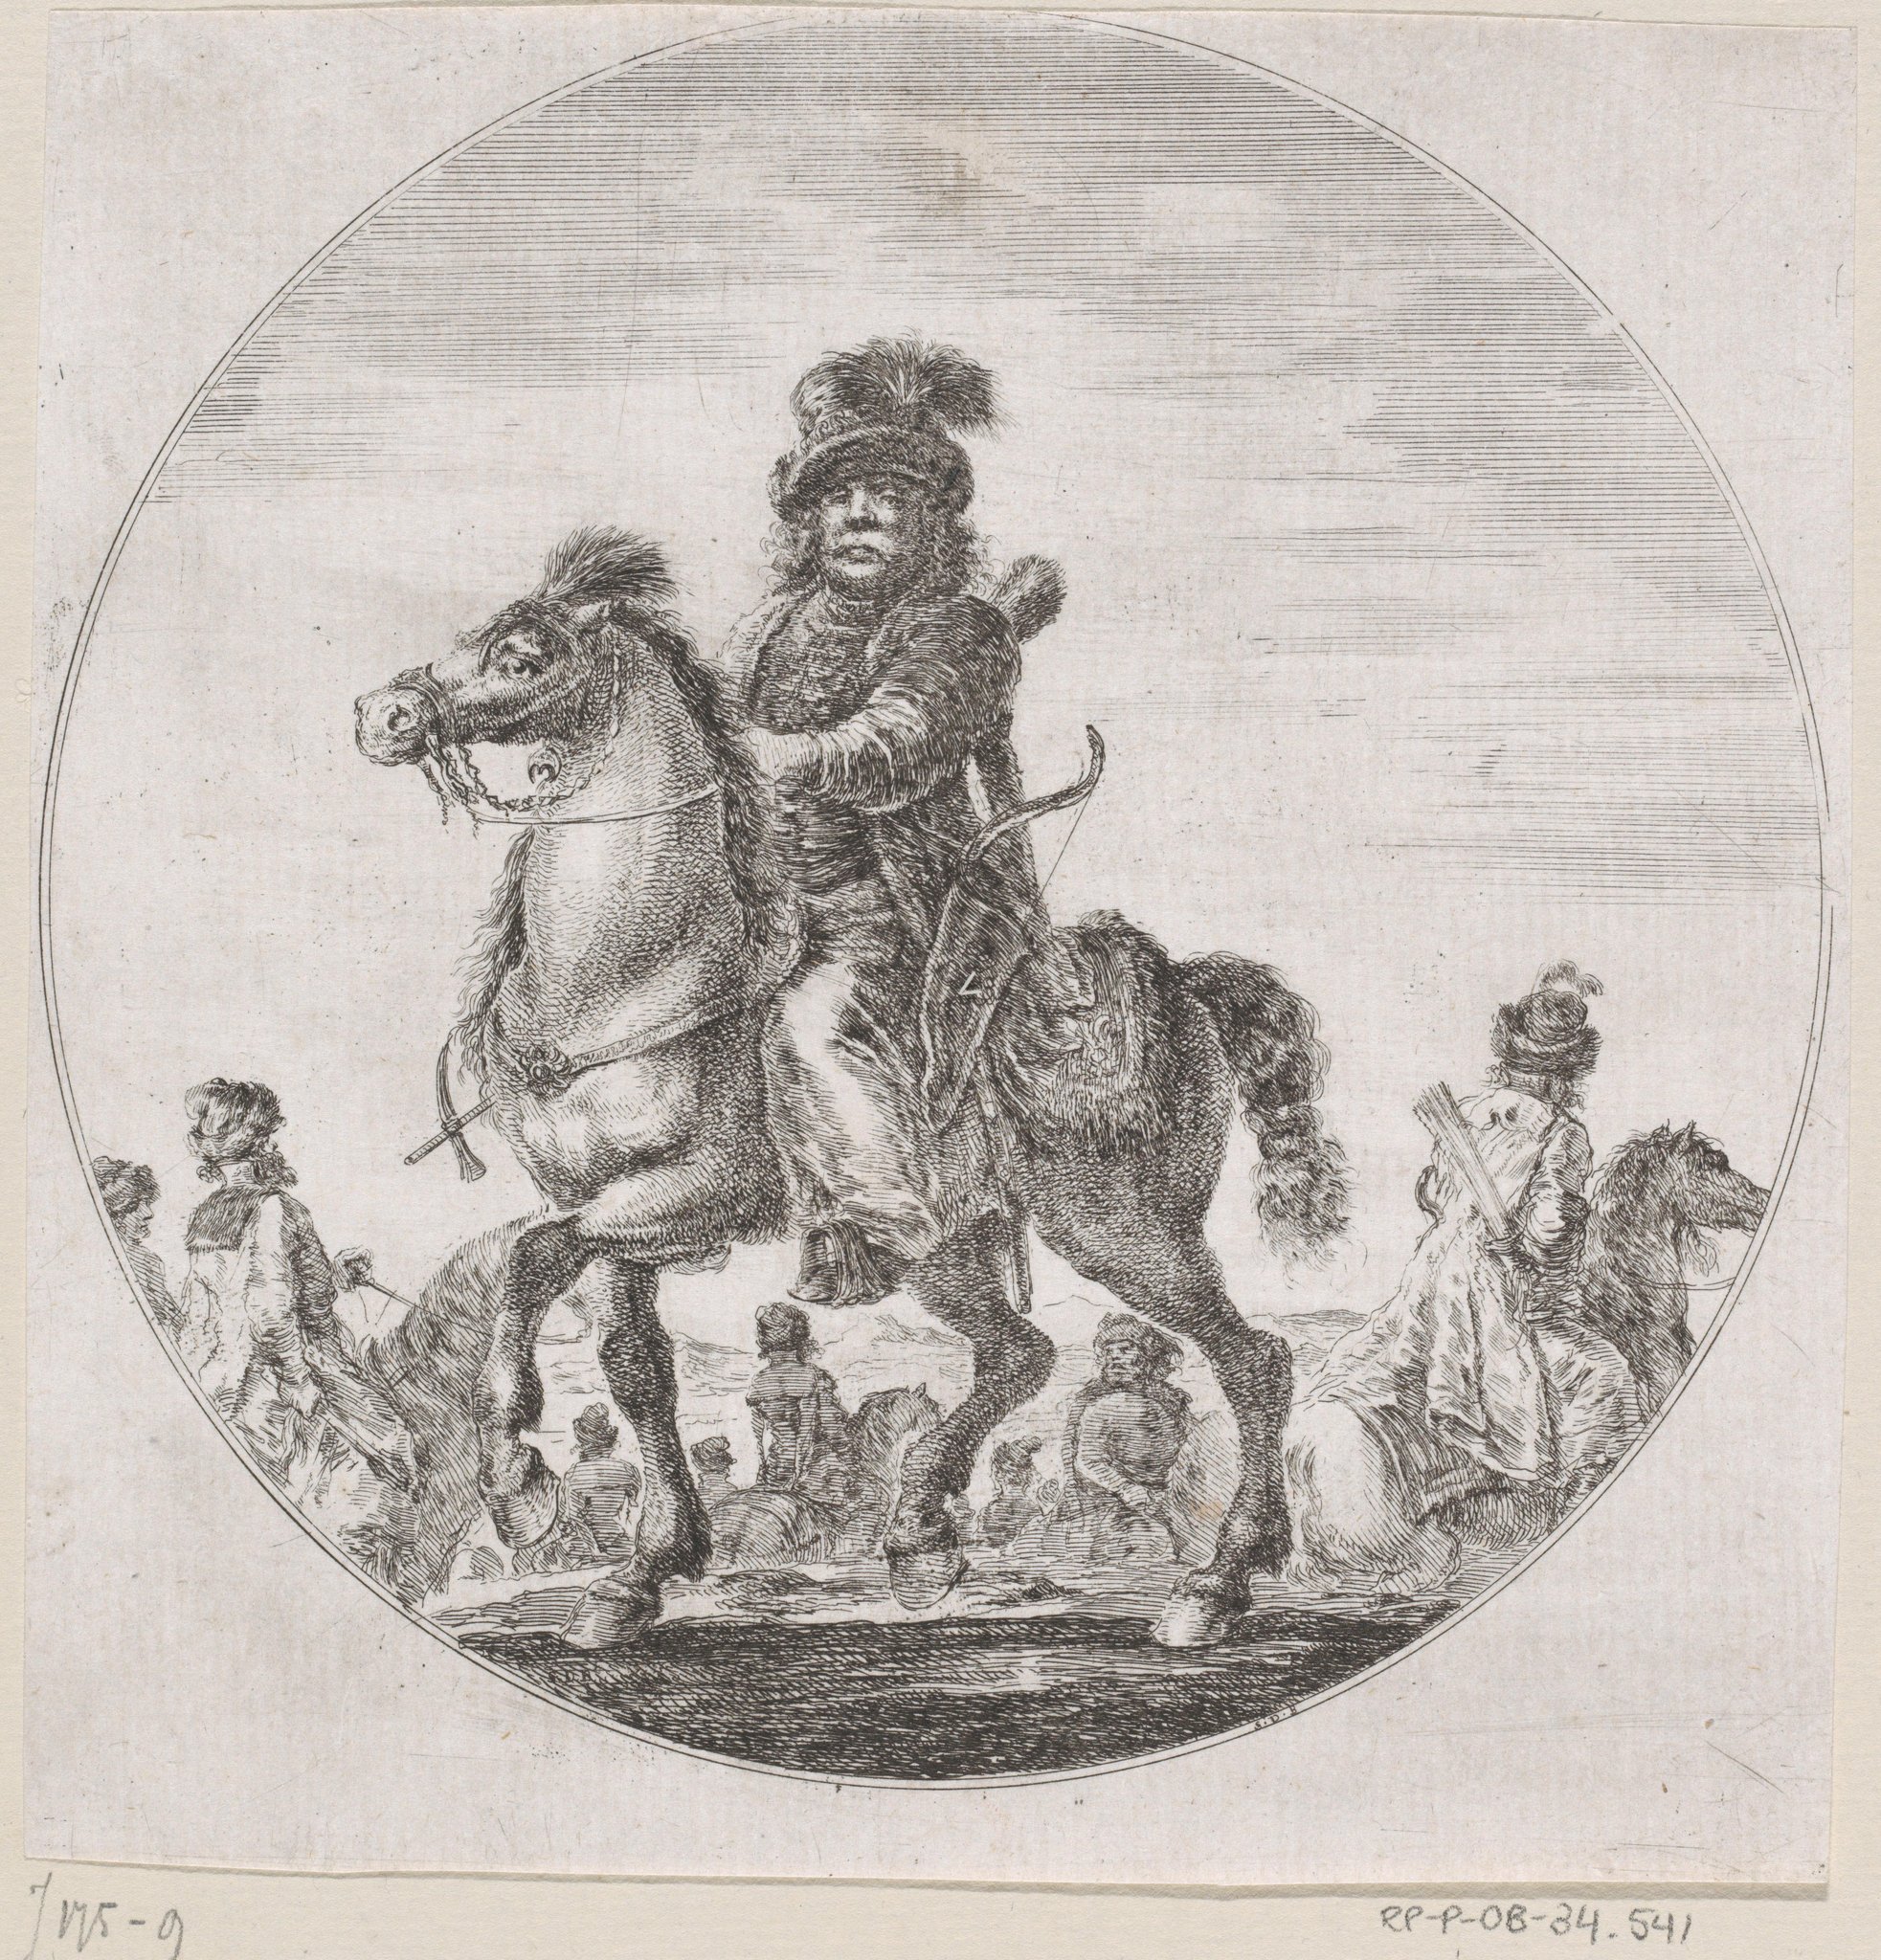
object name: print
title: Hongaarse man met snor te paard naar links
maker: stefano della bella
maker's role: draughtsman, print maker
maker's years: 1610-1664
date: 1620-1664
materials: paper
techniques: etching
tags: europeans, riding a horse, ass, or mule; rider, horseman, moustache, horse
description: Een Hongaarse man met snor en een muts met pluim te paard naar links. Langs zijn zij hangen pijlen en een boog. Op de achtergrond mannen te paard.